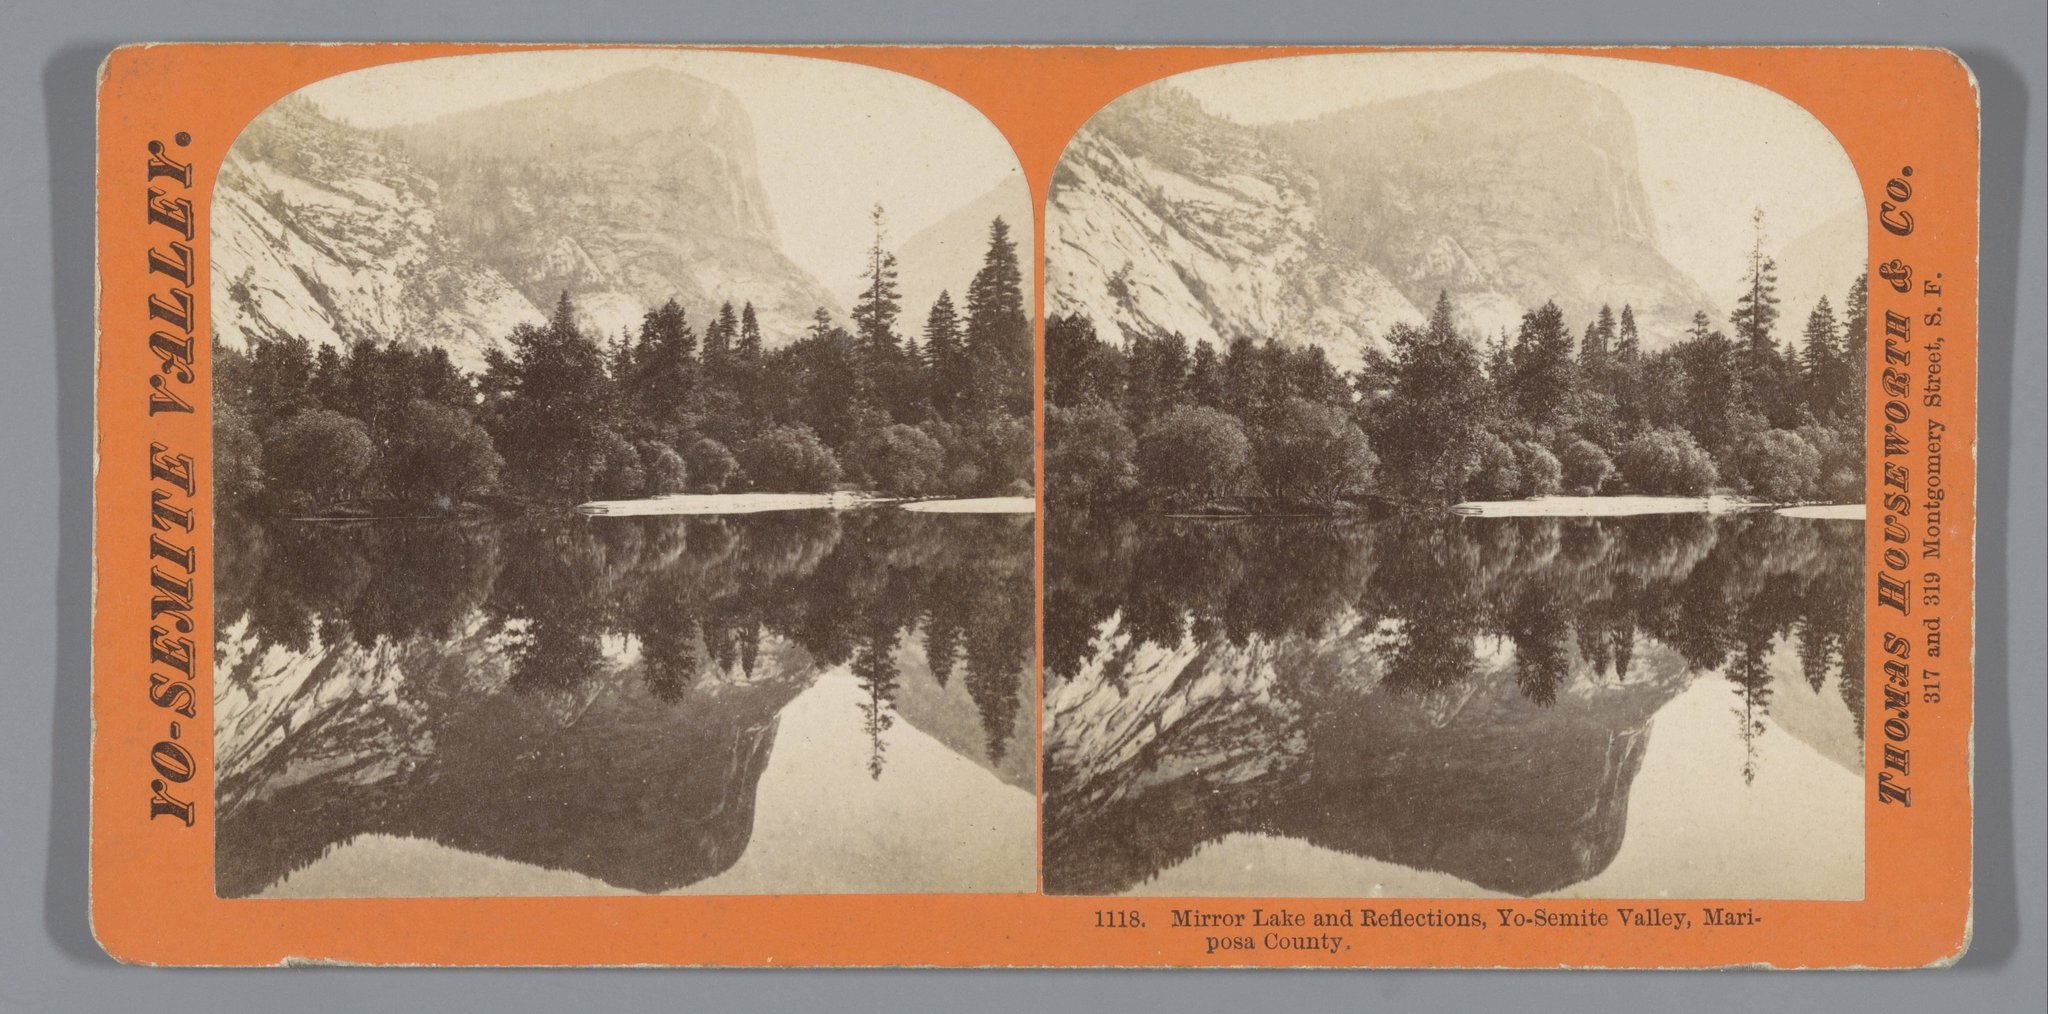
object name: stereograph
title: Gezicht op Mirror Lake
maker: Anonymous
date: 1867-1886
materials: cardboard, paper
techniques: albumen print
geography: san francisco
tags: lake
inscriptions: number: ‘1118’